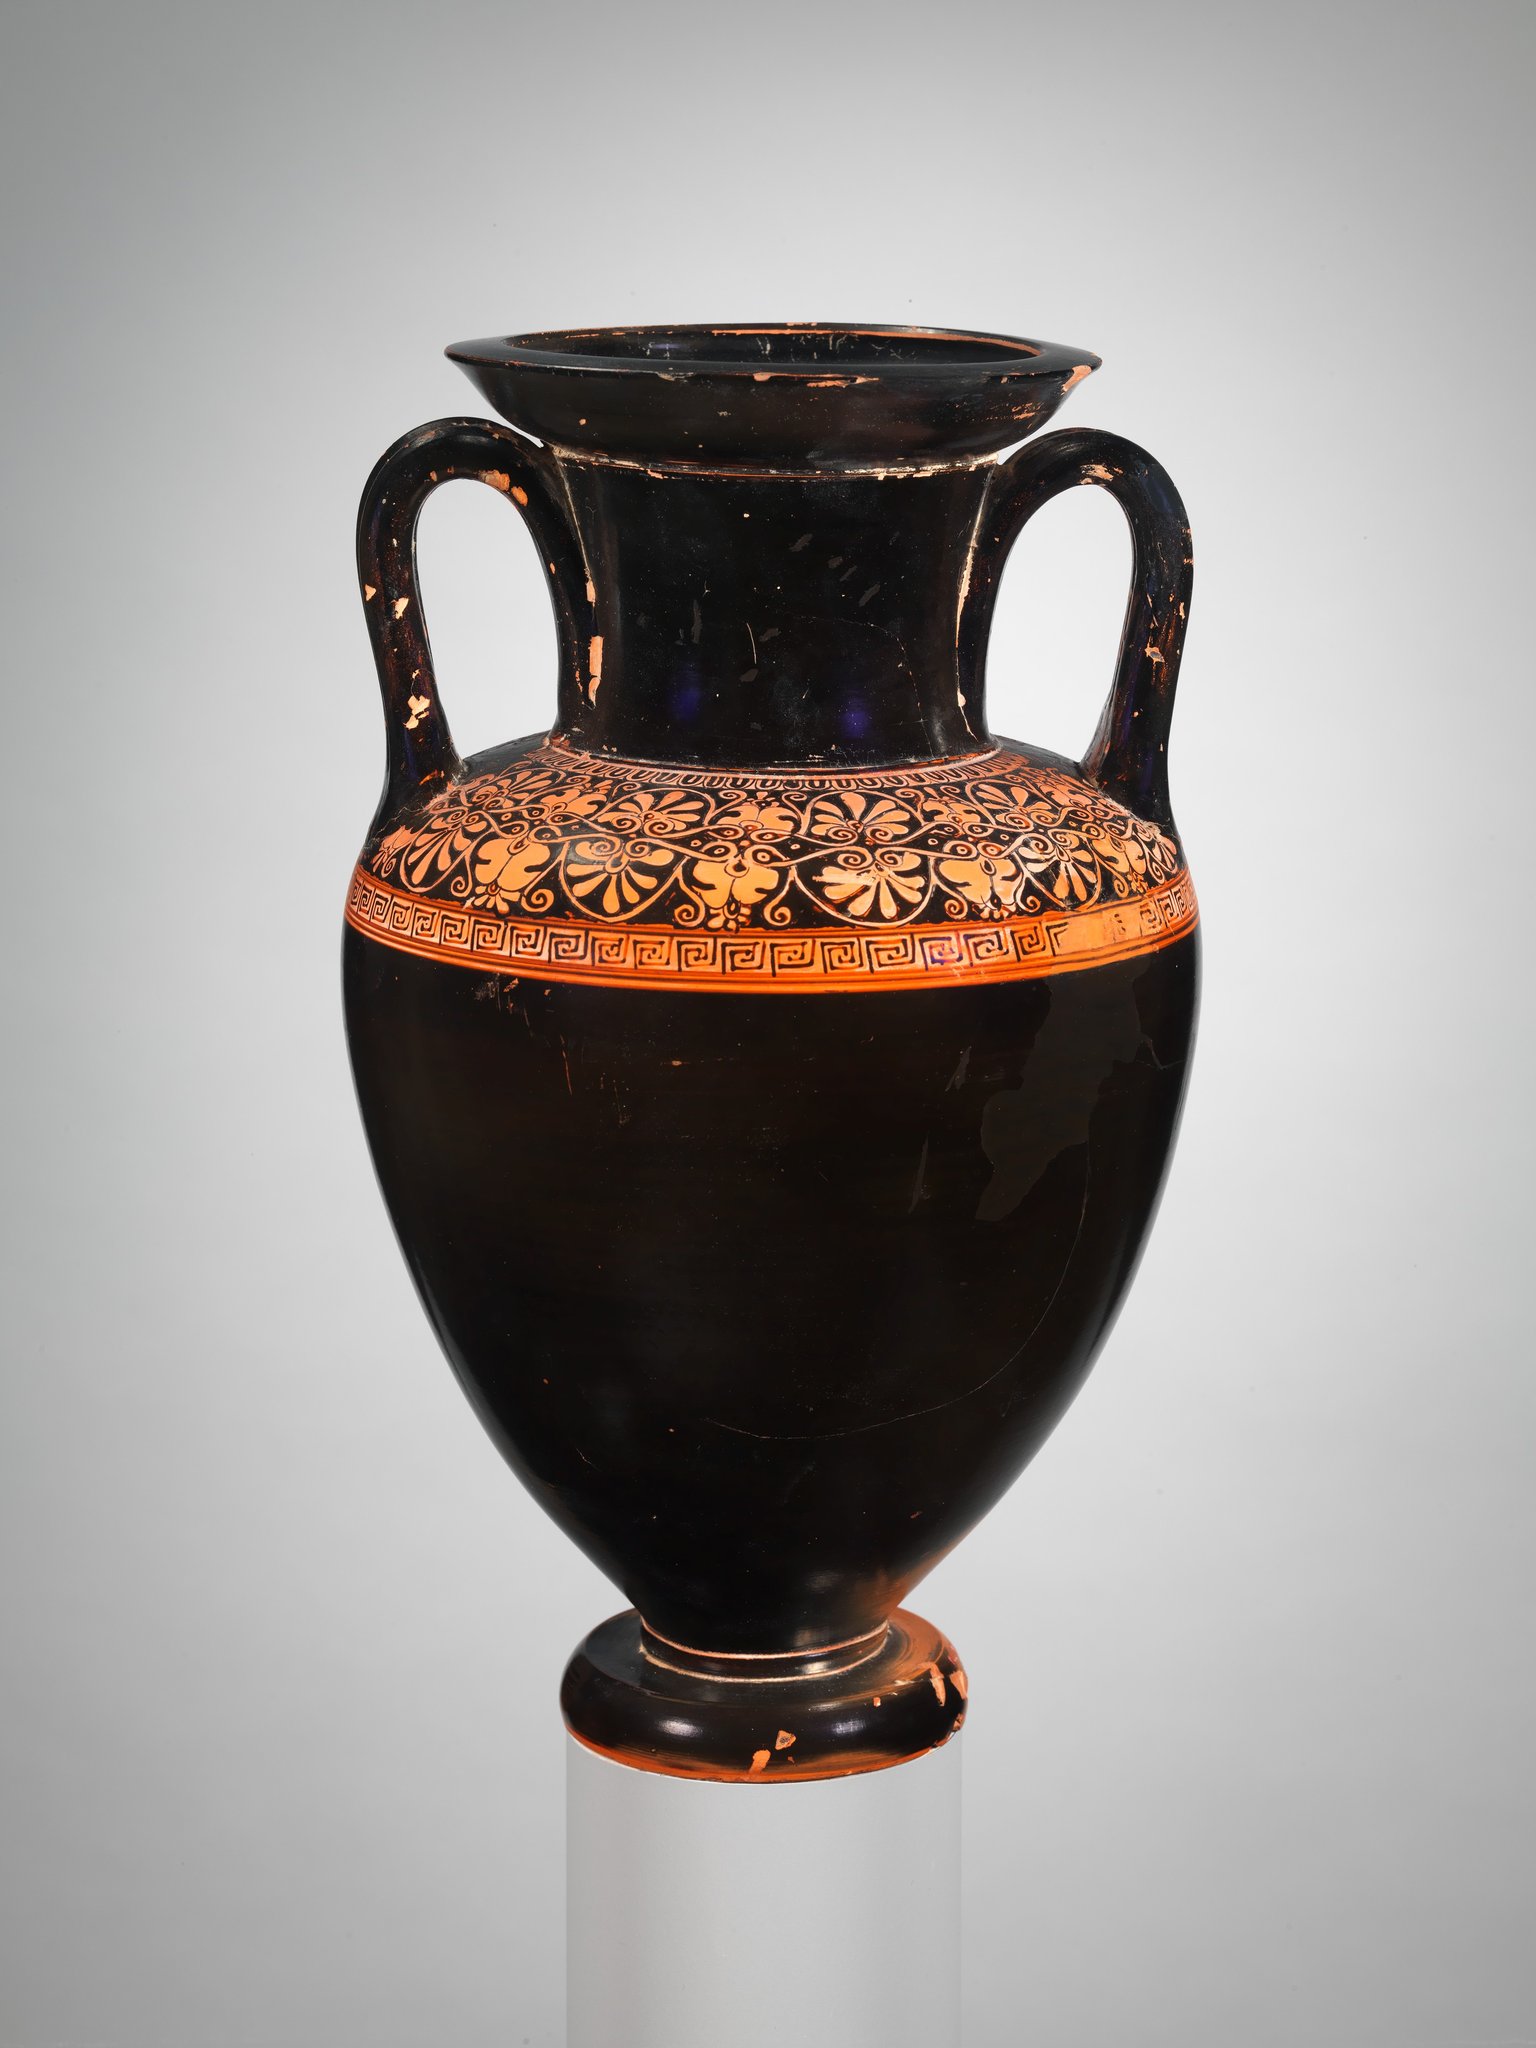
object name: nolan neck amphora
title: Terracotta Nolan neck-amphora (jar)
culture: greek, attic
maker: group of the floral nolans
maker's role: artist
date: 480 BCE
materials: terracotta